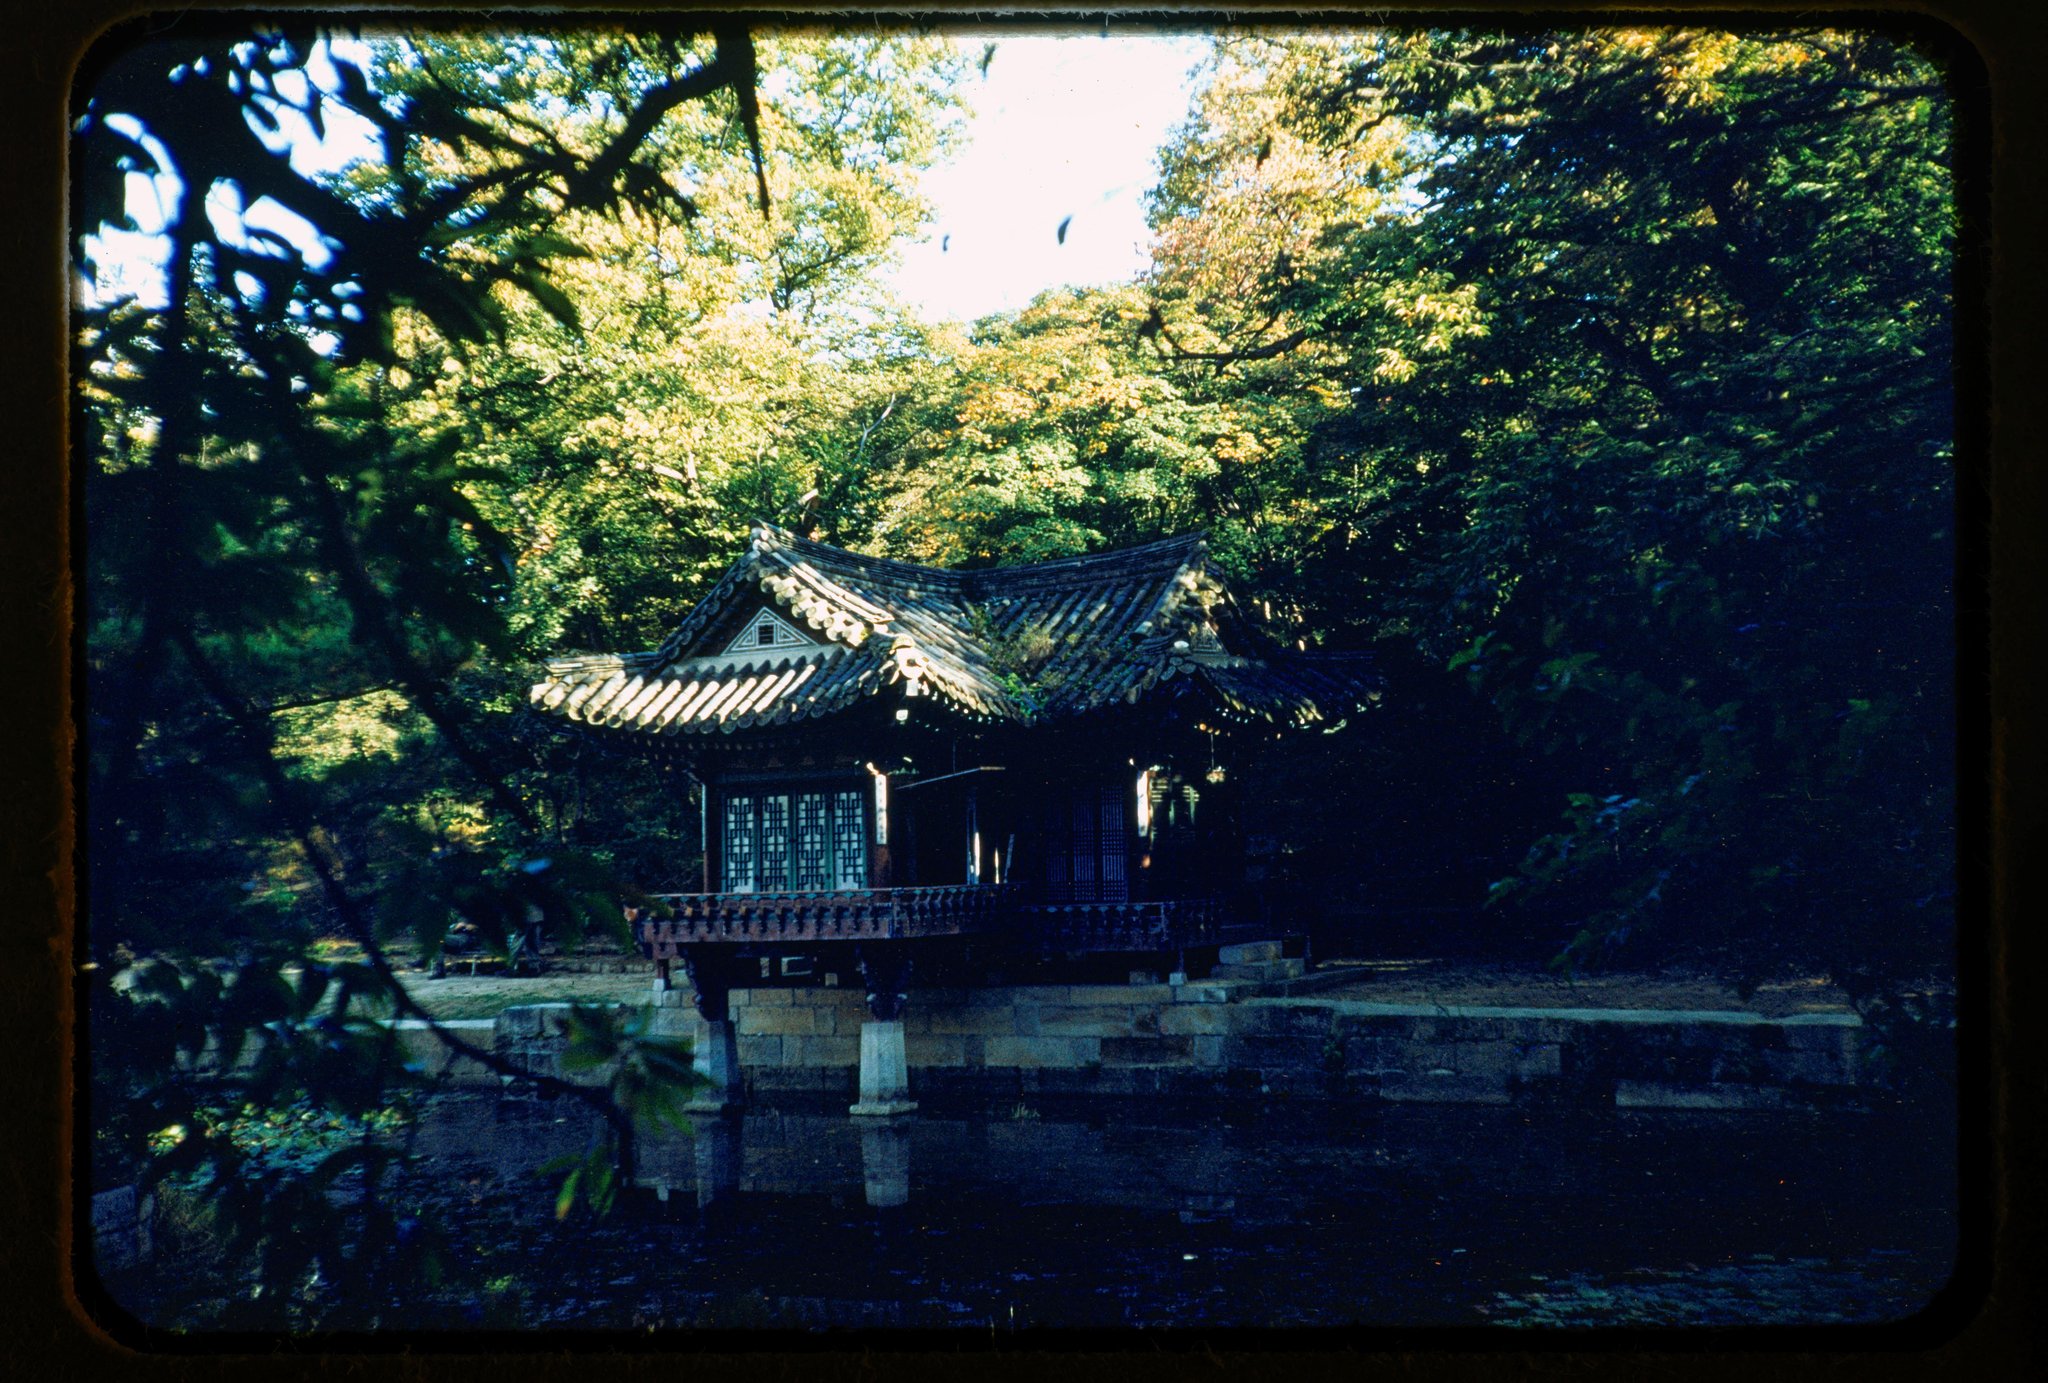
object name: color slide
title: Het oude keizerlijke zomerpaleis in Seoul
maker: david ketel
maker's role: diplomaat, sinoloog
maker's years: 1913-2008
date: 1952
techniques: slide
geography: seoul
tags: united nations